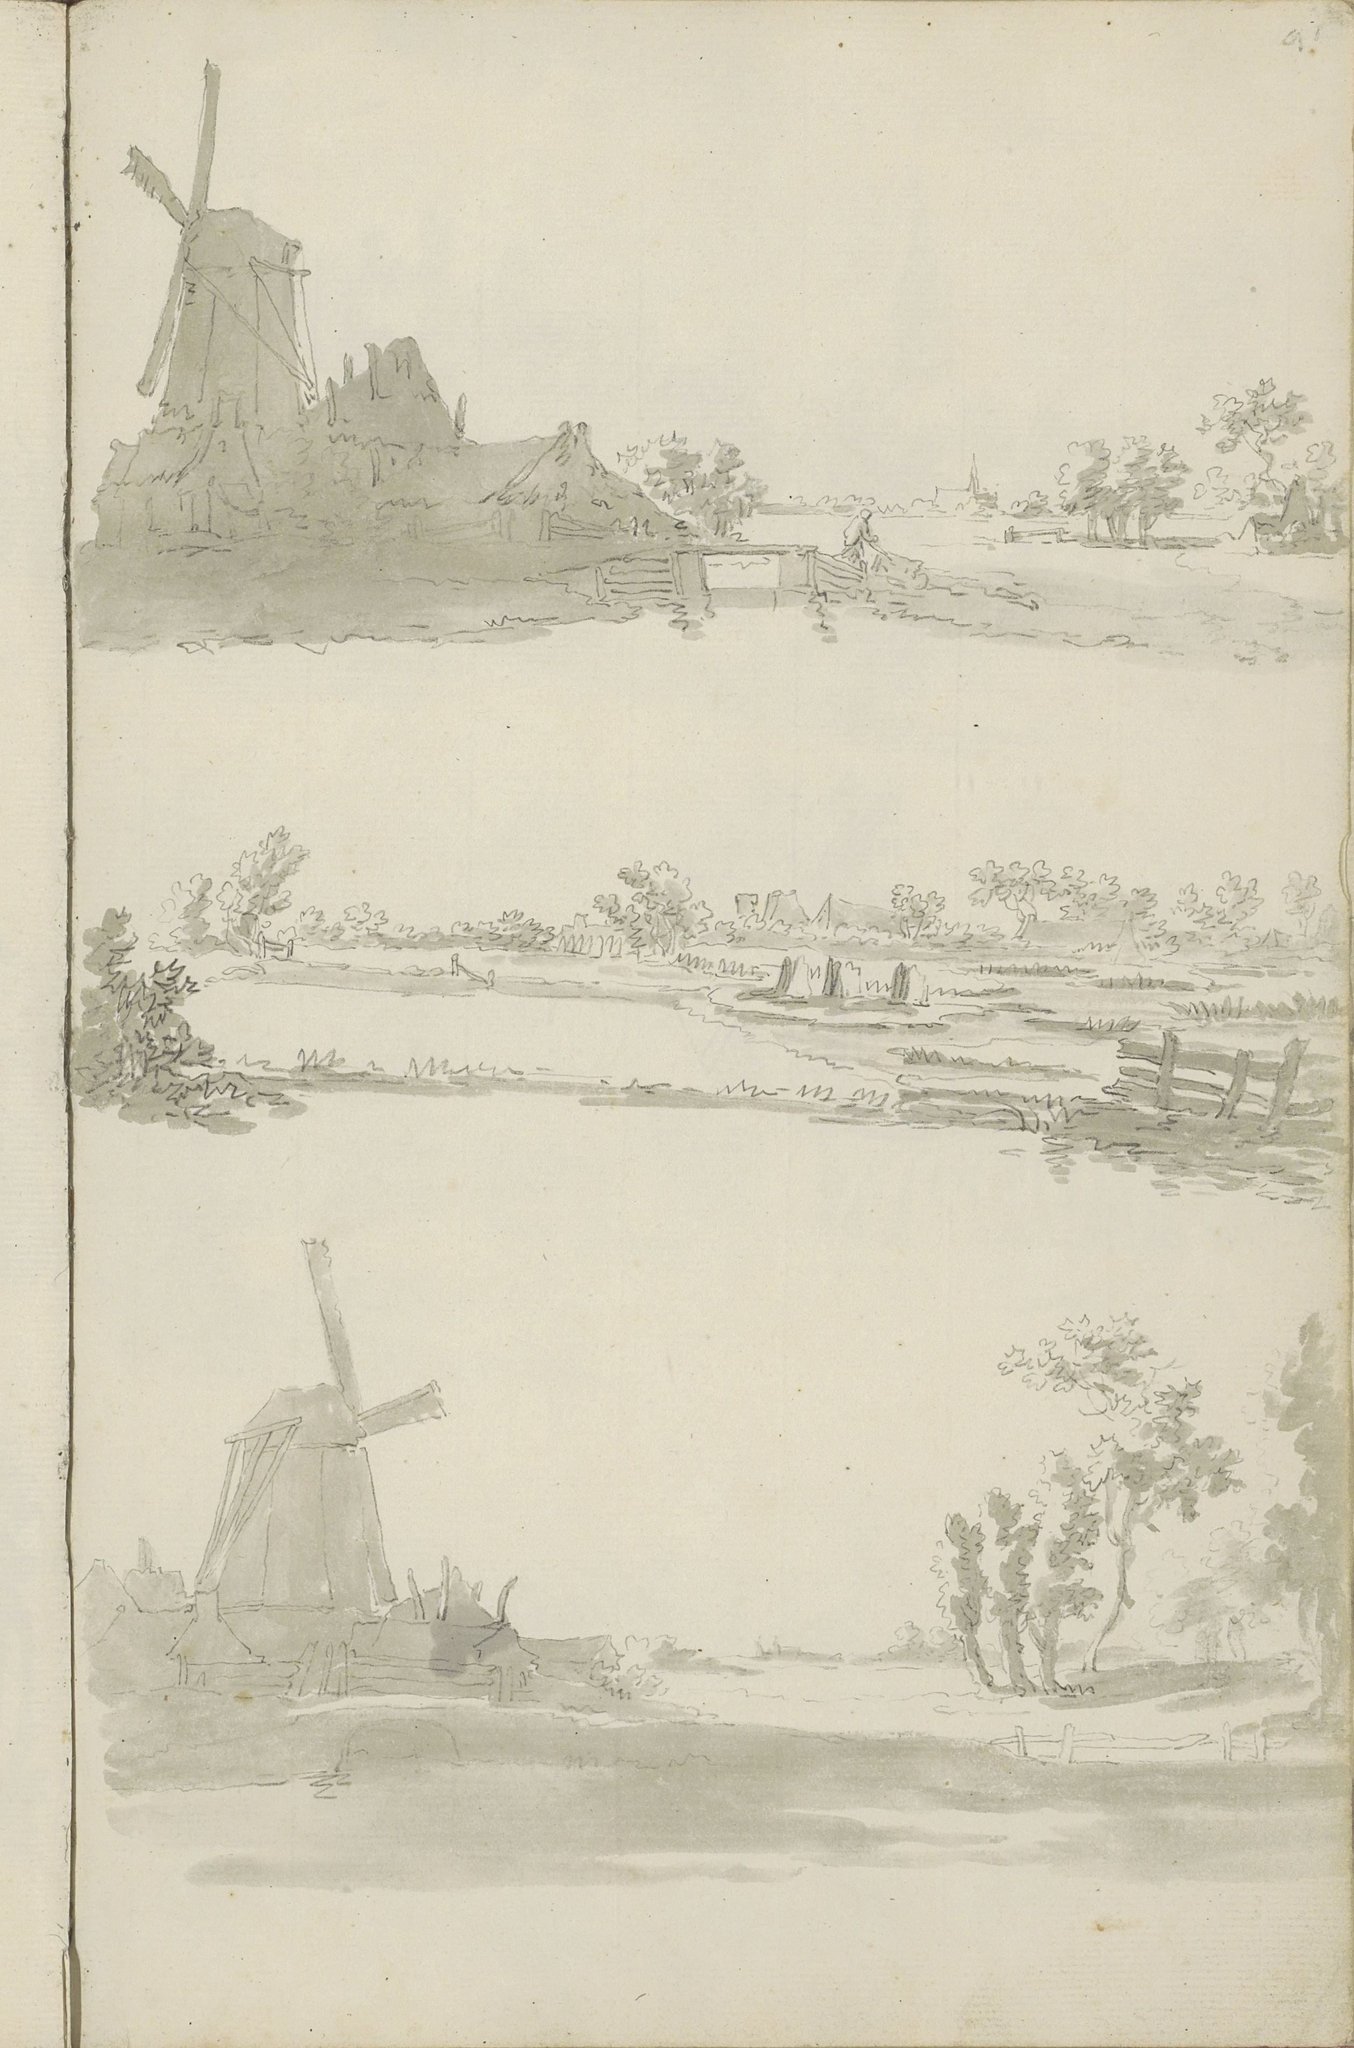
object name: sketchbook leaf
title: Landschappen met molens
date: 1780-1800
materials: paper, pencil, watercolor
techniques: brush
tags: windmill in landscape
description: Blad 18 recto uit een schetsboek met 25 bladen.